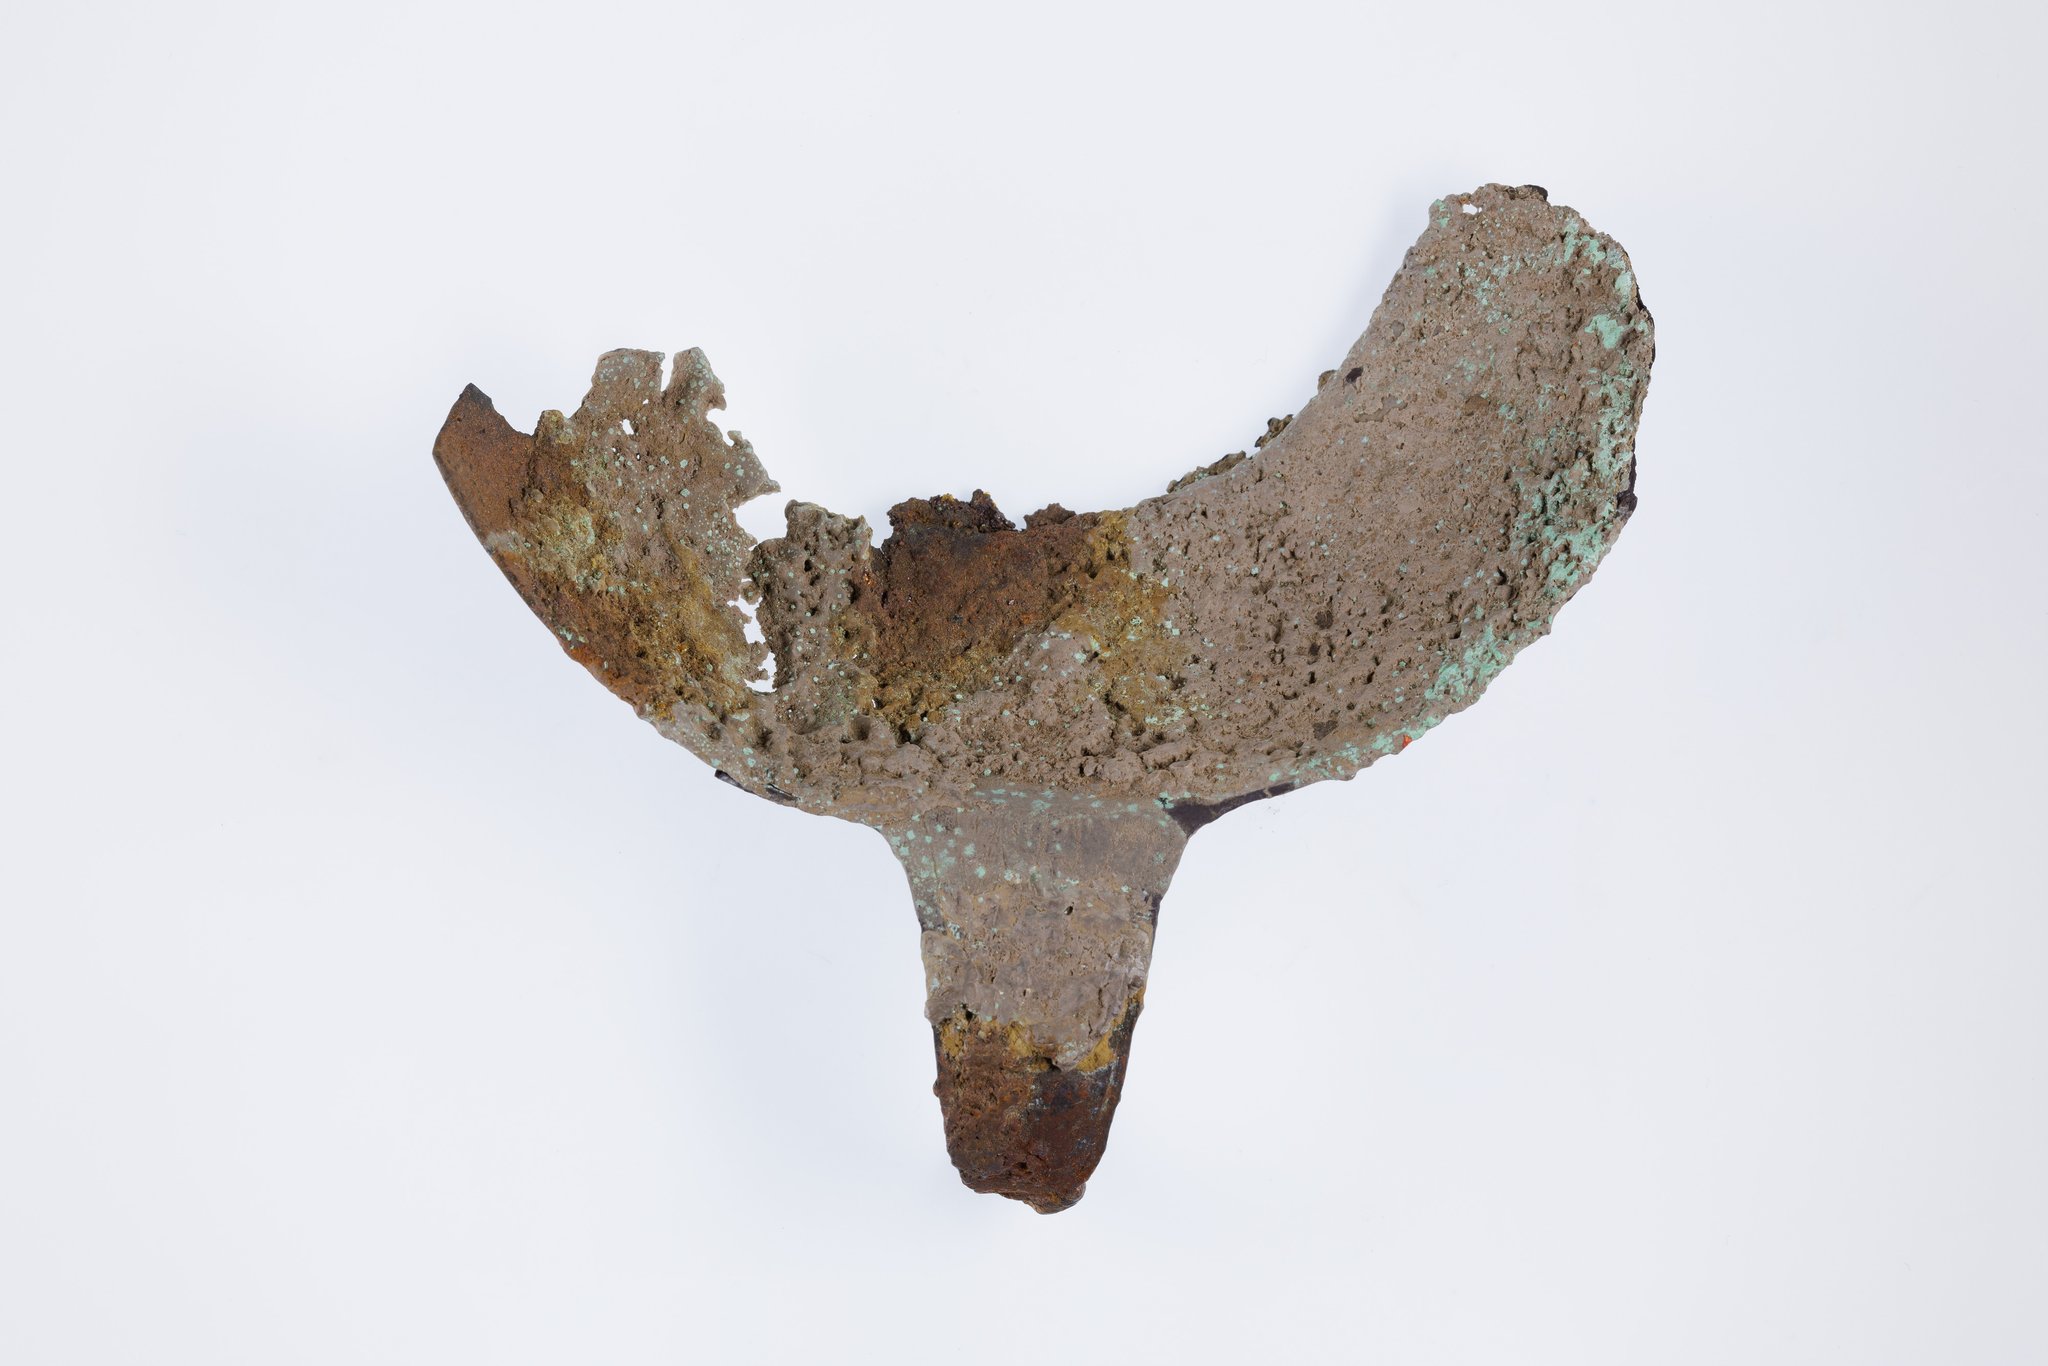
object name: vessel fragment, tell basta treasure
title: Part of a shallow strainer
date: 1070-712 BCE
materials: silver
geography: egypt